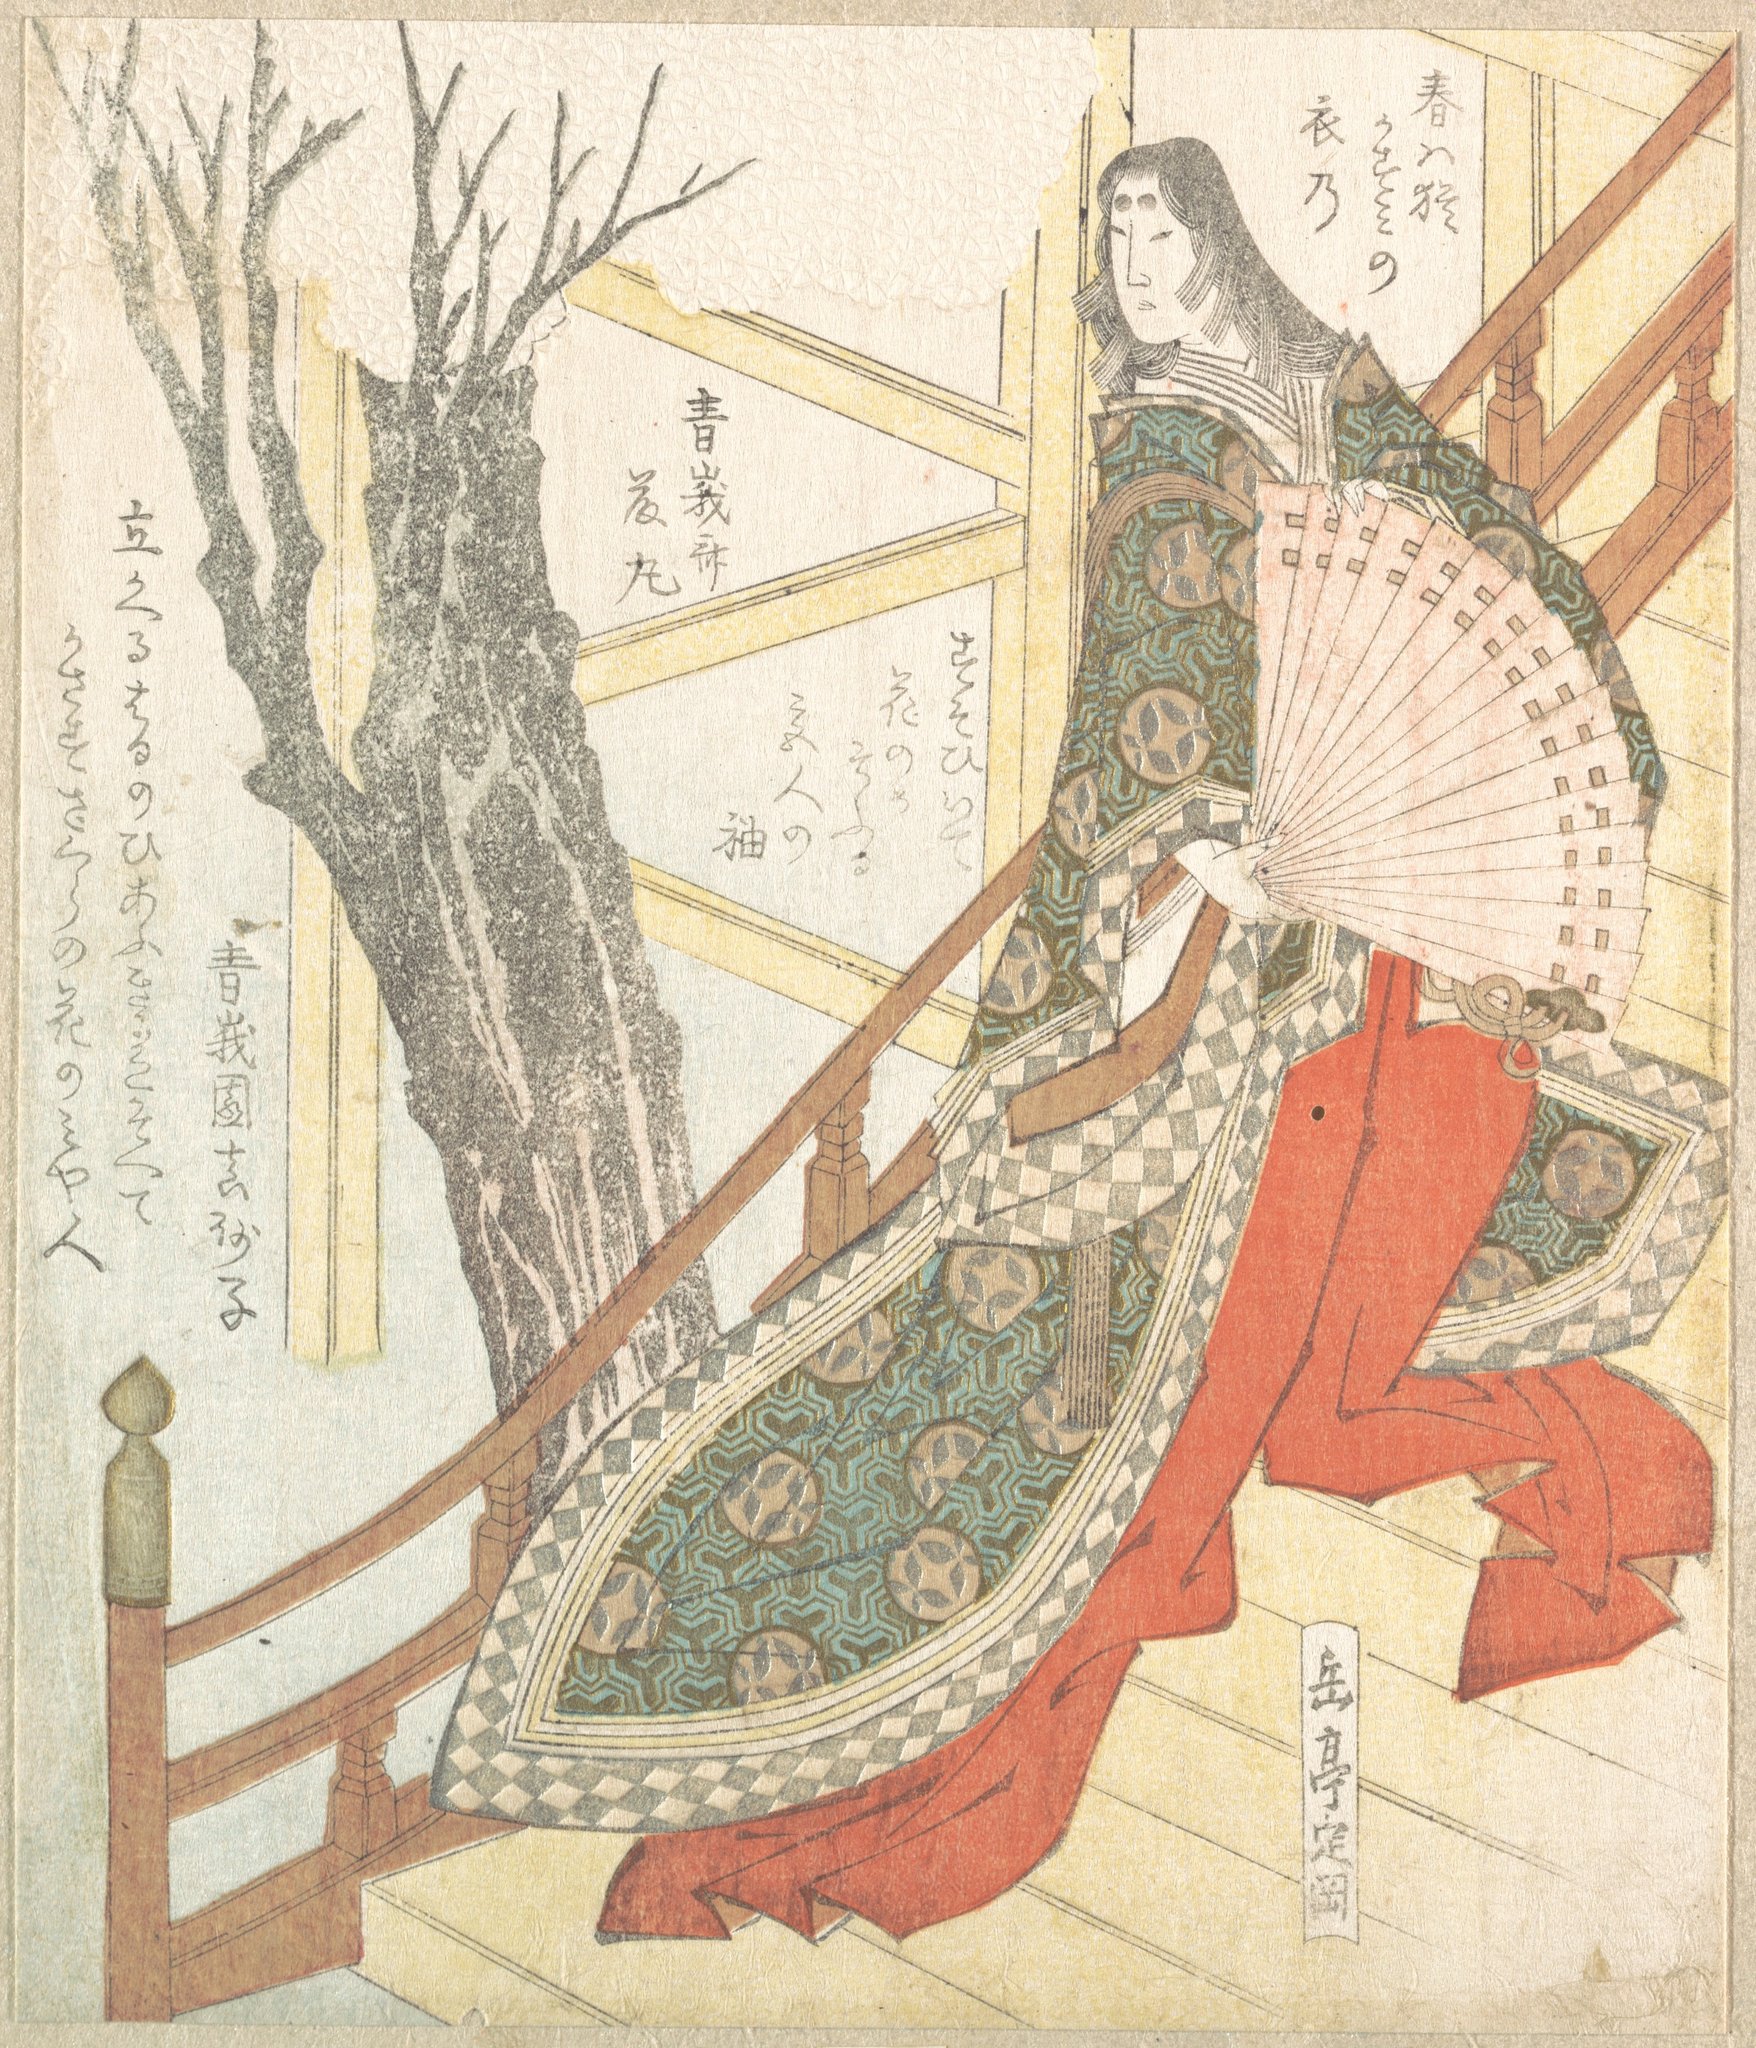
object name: print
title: Court Lady with a Fan—a Cherry-Tree in Bloom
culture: japanese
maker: yashima gakutei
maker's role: artist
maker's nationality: japanese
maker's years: 1786-1868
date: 1801-1900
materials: ink, paper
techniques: surimono, woodblock print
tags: fans,women